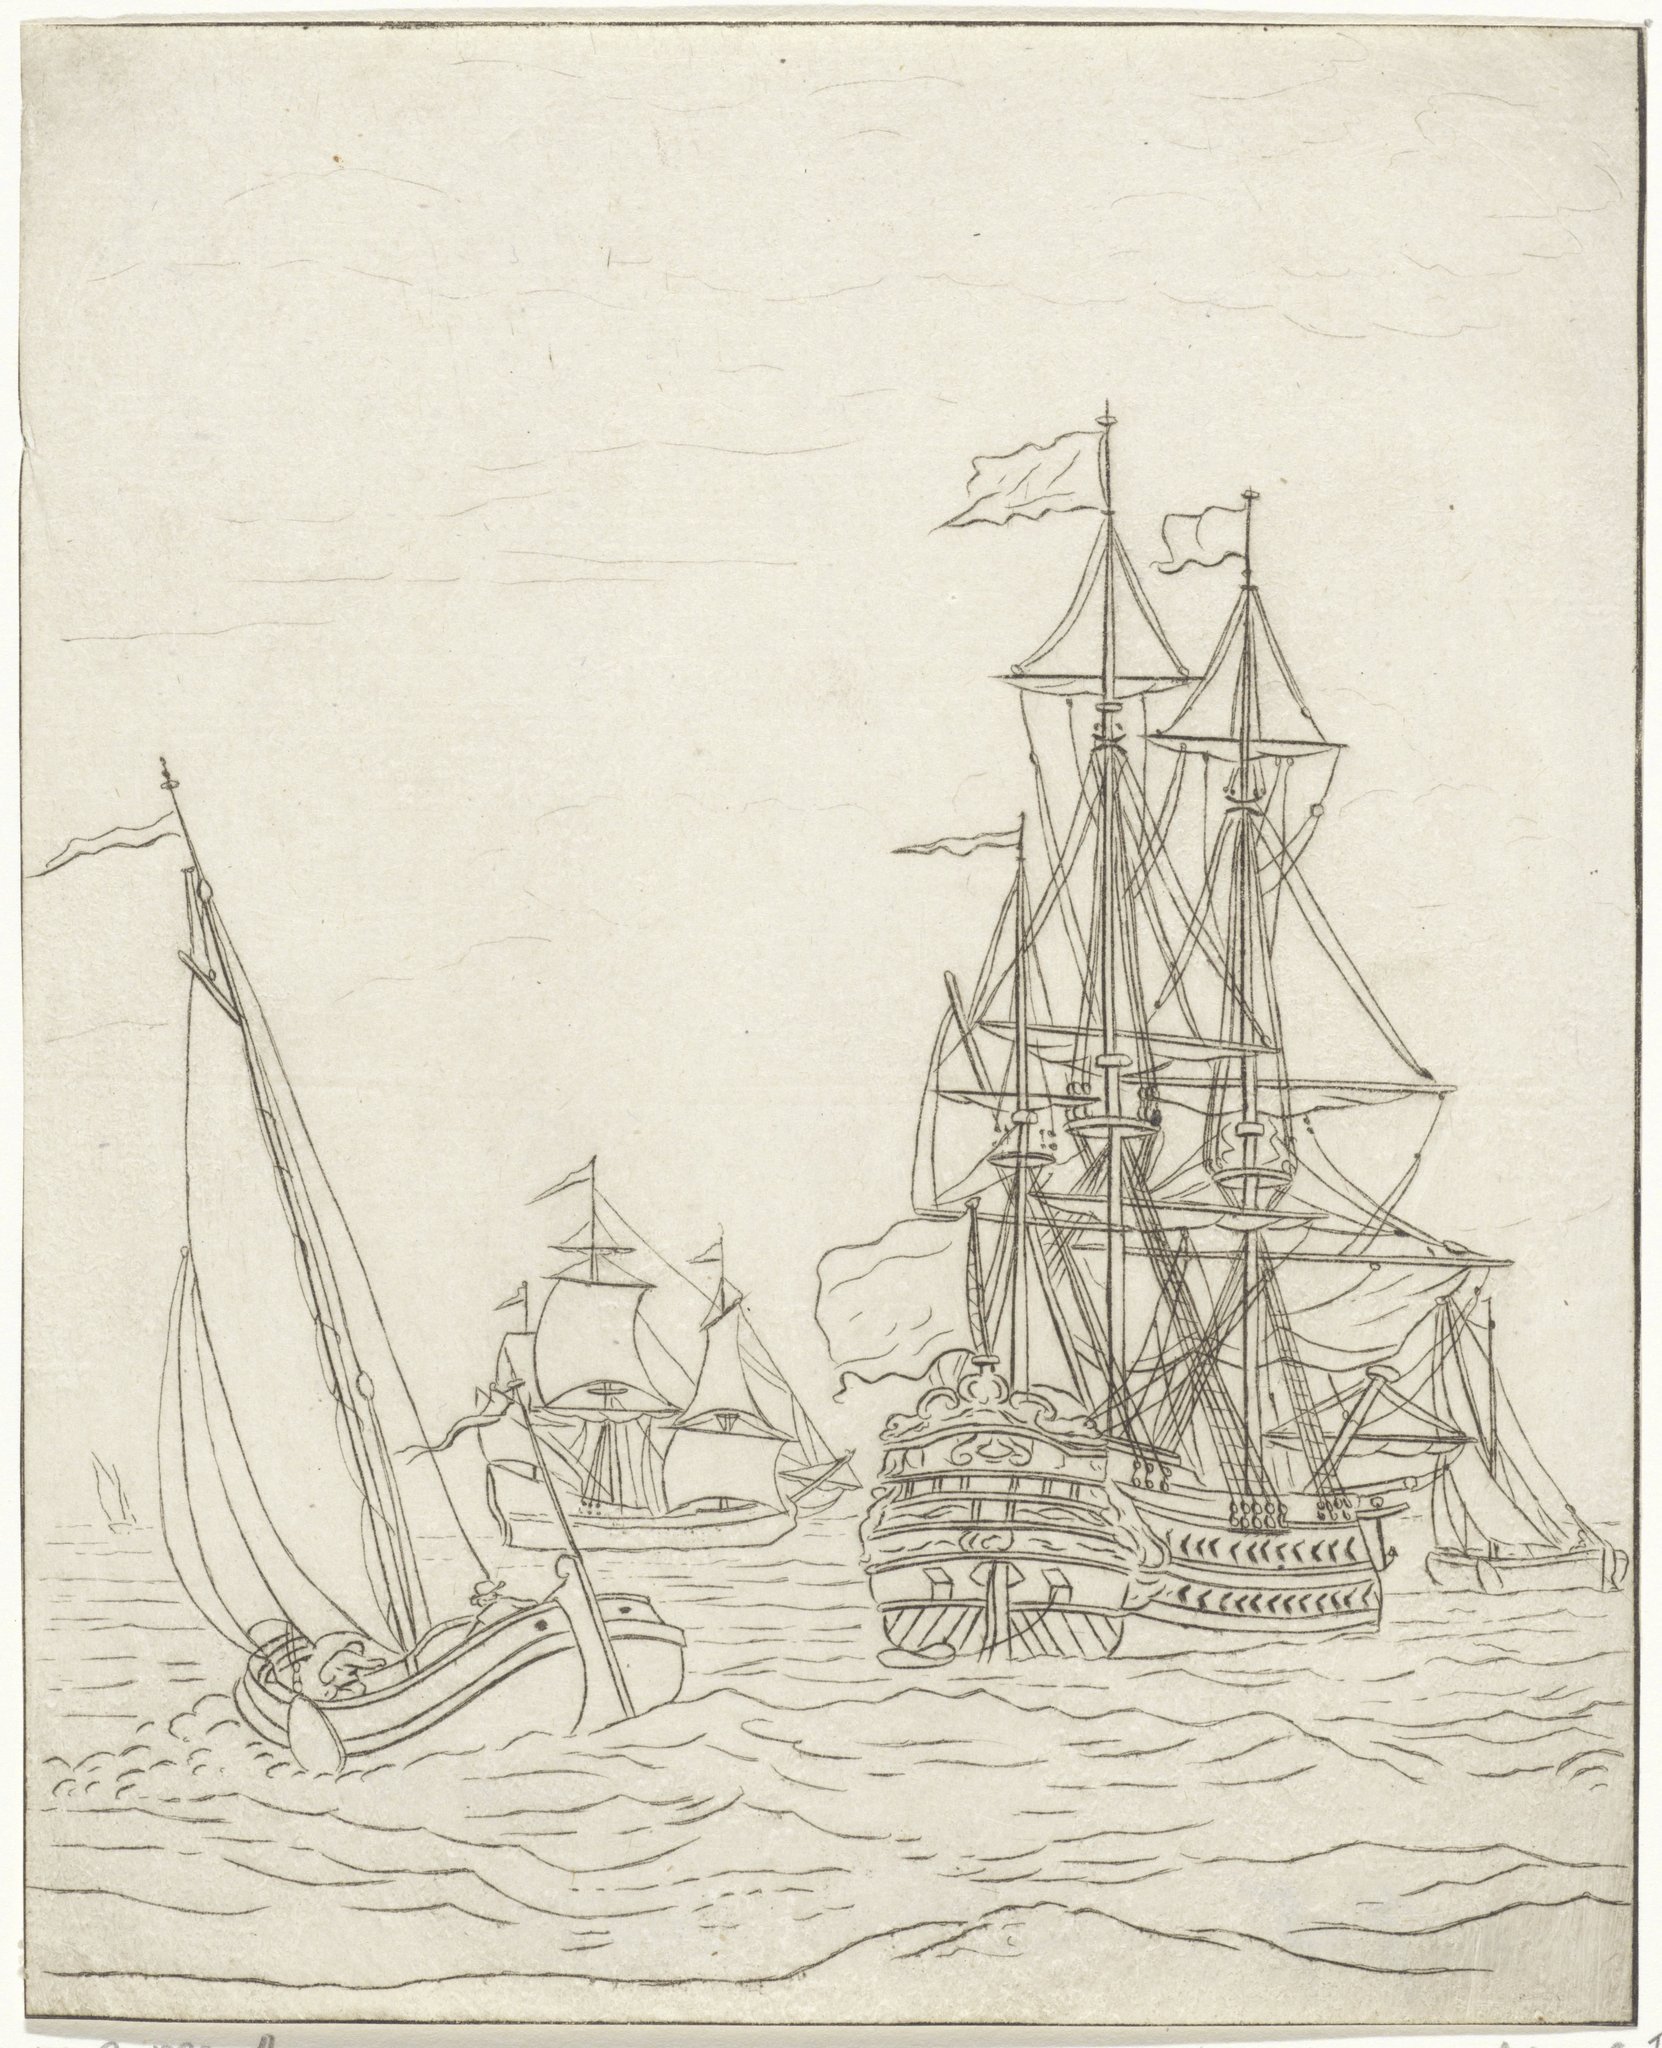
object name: print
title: Oorlogschip en drie zeilschepen op volle zee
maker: bernhard schreuder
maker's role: print maker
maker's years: -1780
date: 1767-1780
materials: paper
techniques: etching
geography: netherlands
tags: sailing-ship, sailing-boat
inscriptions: collector's mark: Lugt 2228